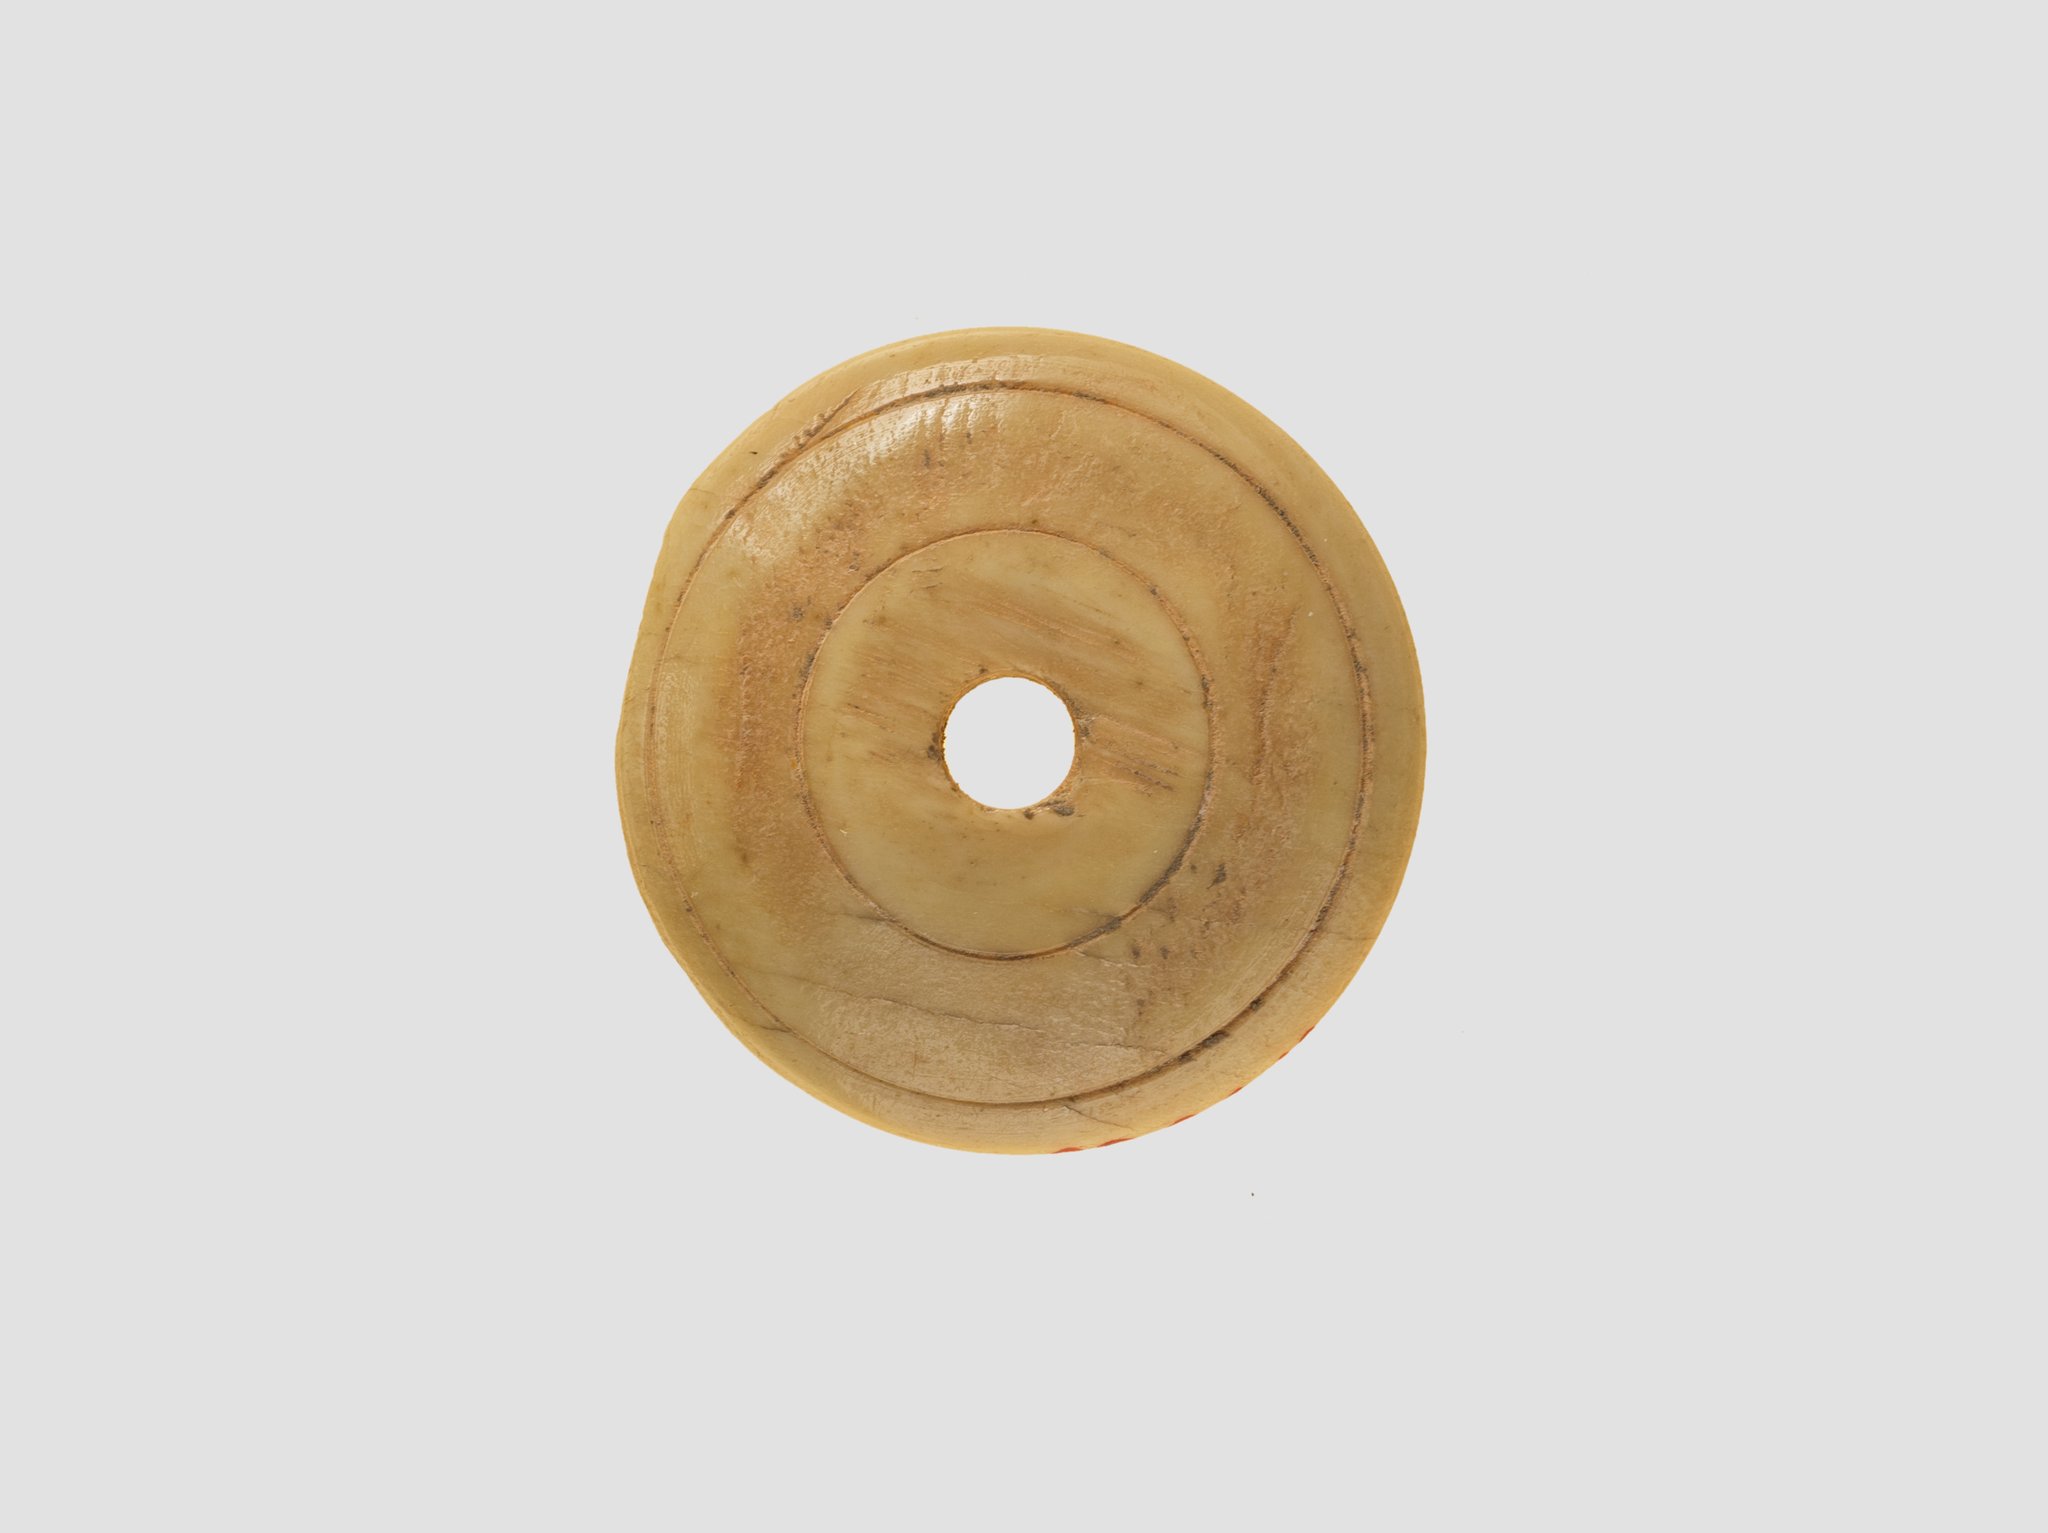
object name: button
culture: iranian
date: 900-601 BCE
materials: bone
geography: iran